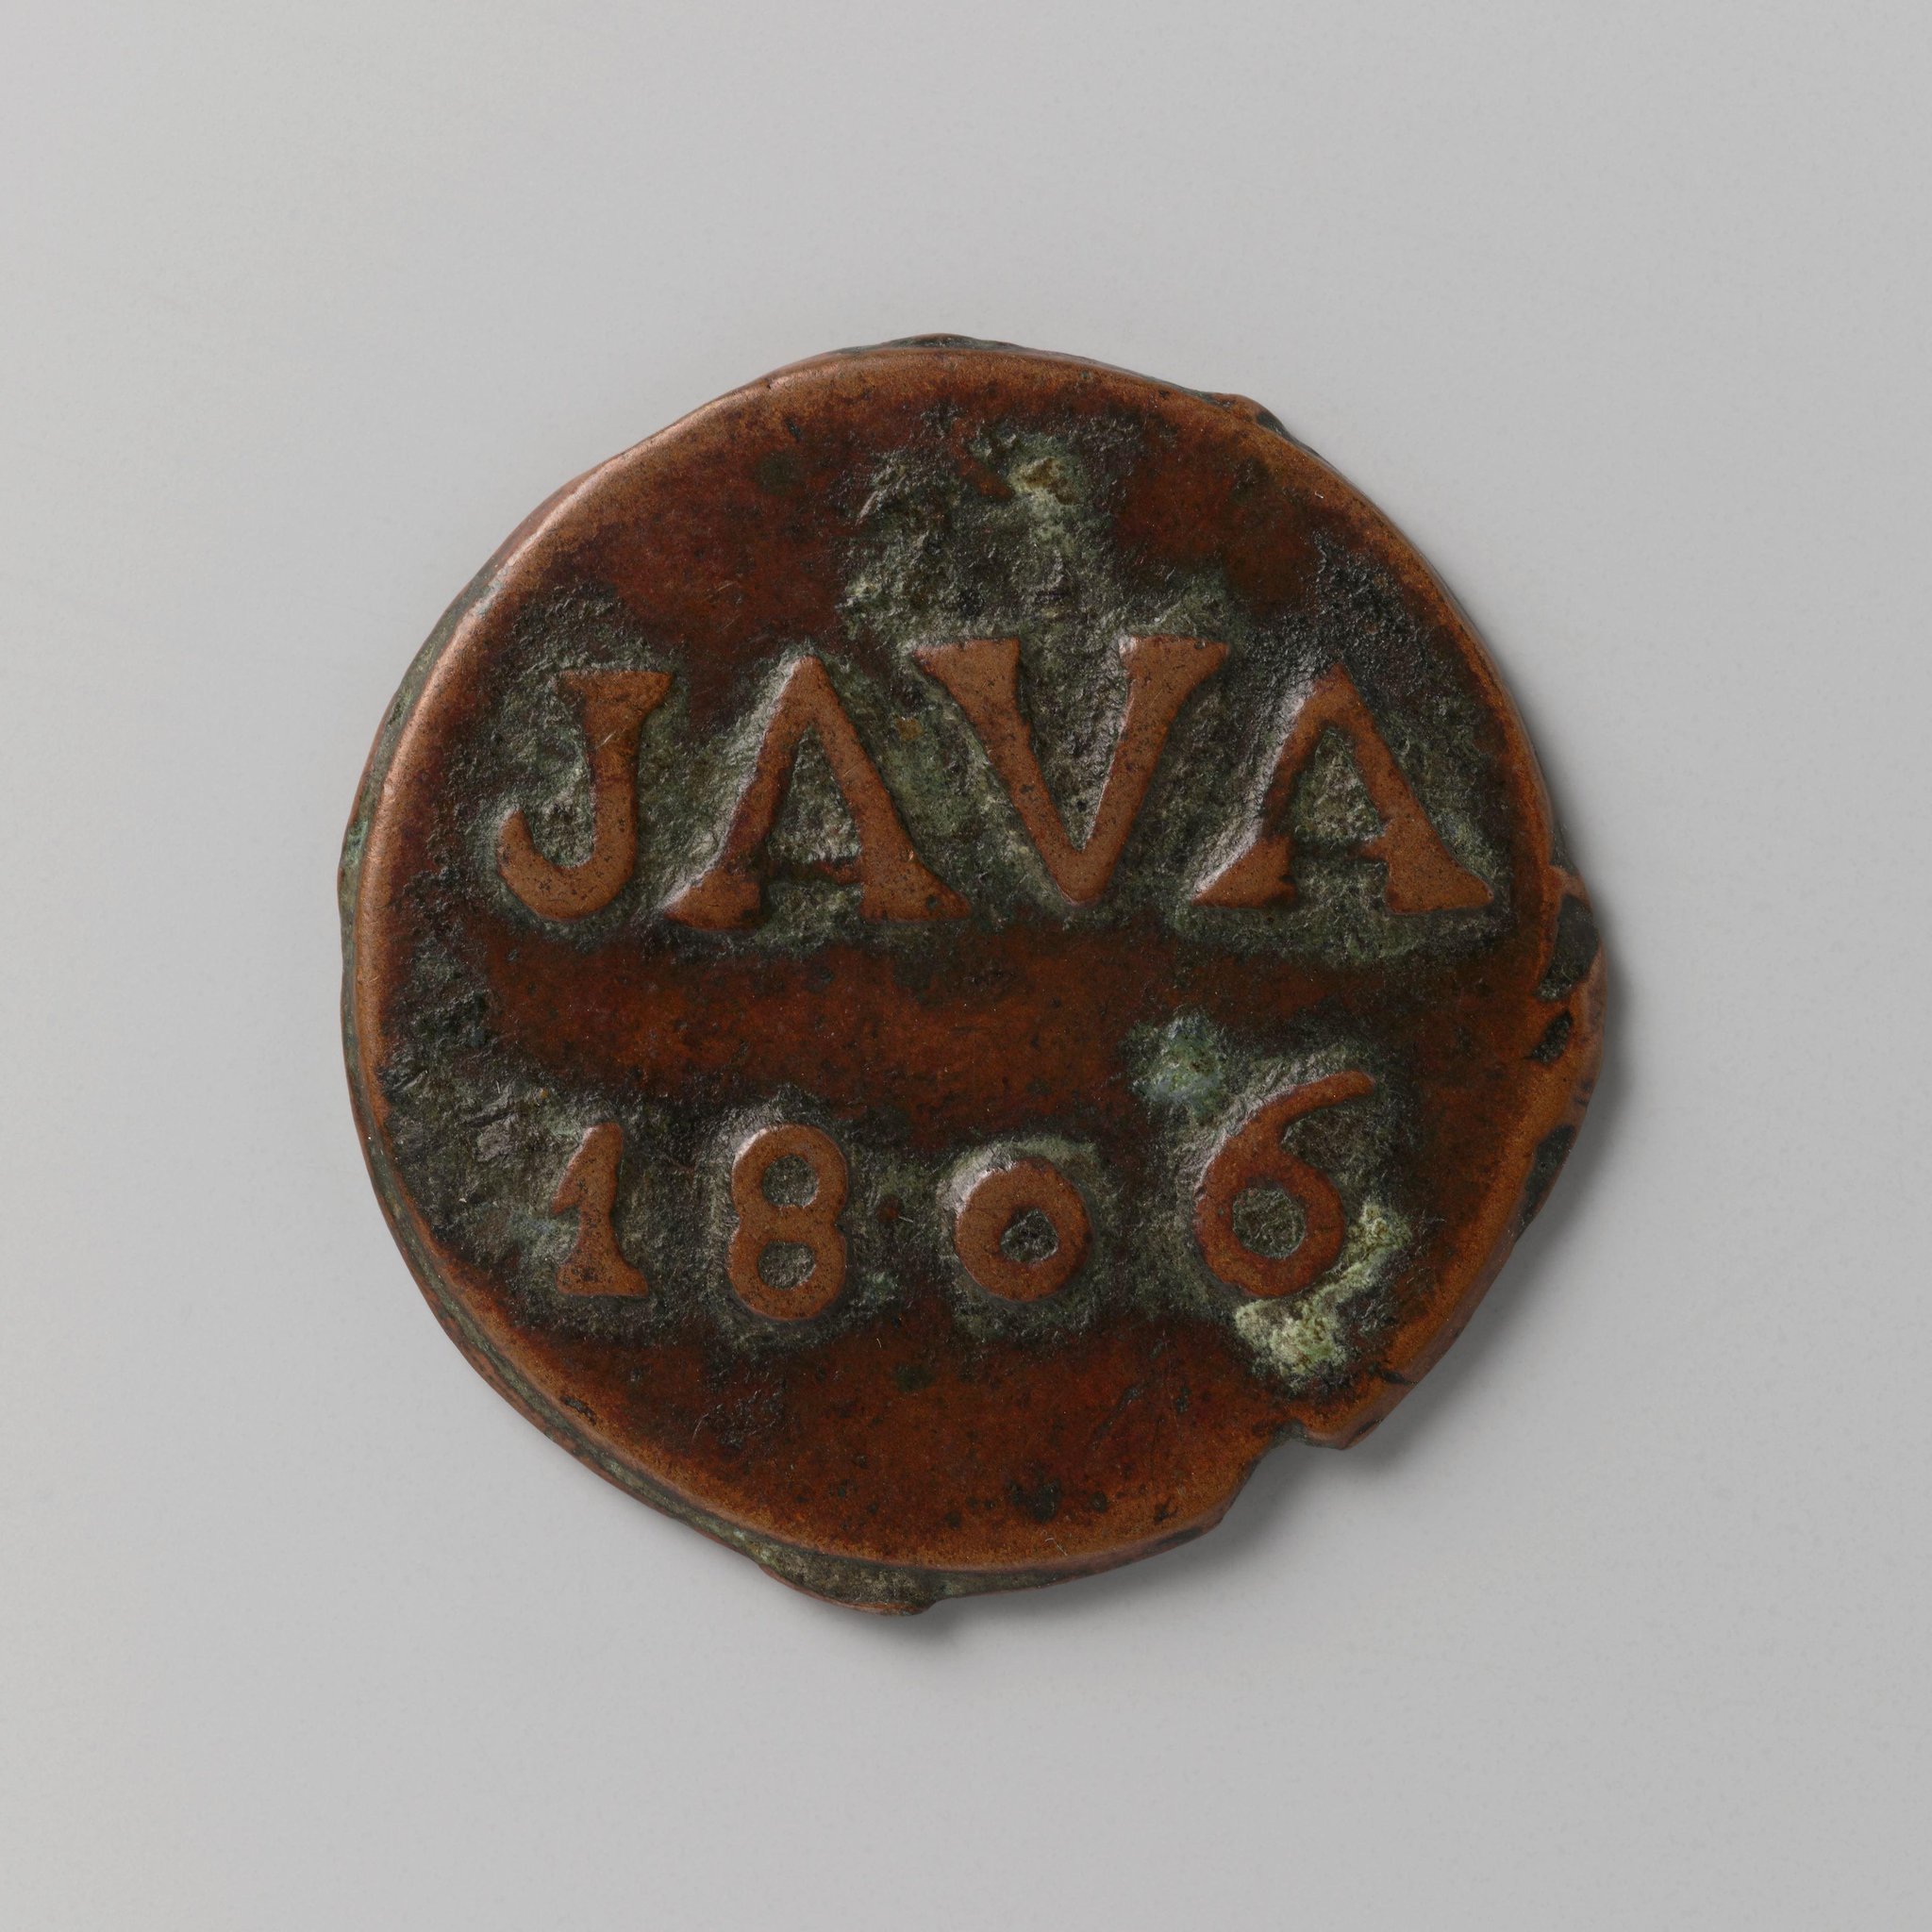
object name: coin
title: Nederlands Indië, duit Java,1806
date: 1806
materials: copper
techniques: striking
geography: surabaya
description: Koperen munt. Voorzijde: opschrift, JAVA, waarboven muntteken en waaronder jaartal. Keerzijde: monogram van de VOC. Daarboven muntteken. Gladde rand.